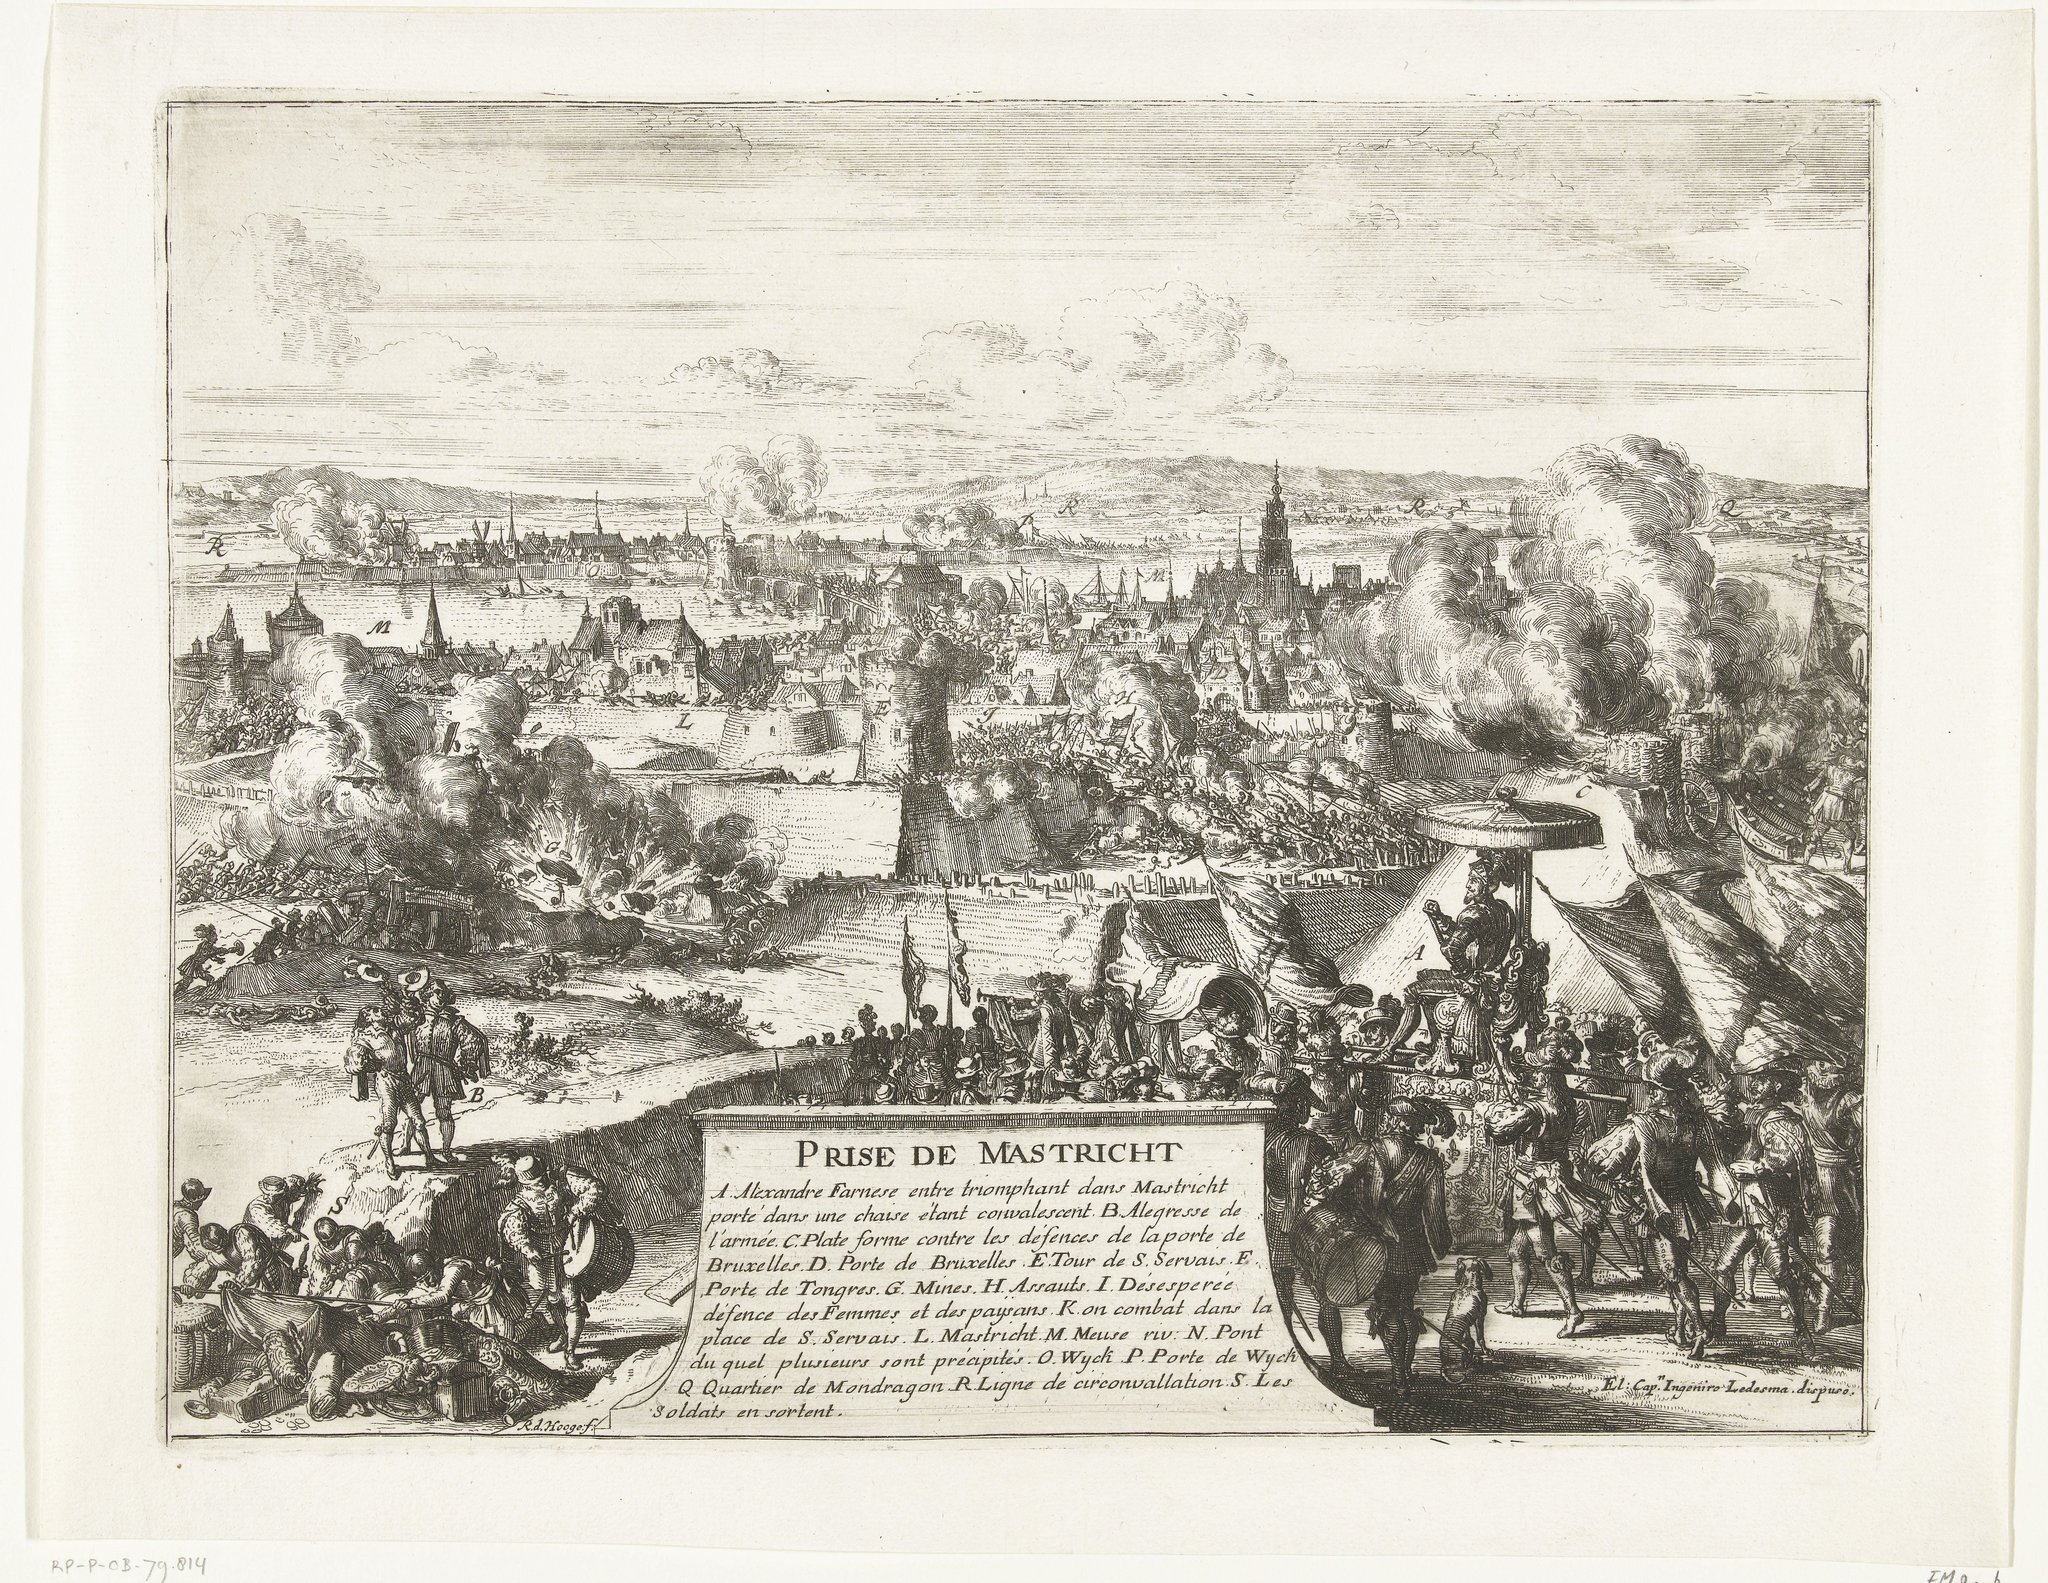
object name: history print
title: Inname van Maastricht door de hertog van Parma, 1579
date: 1670-1699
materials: paper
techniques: etching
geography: northern netherlands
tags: rome, alessandro farnese (landvoogd van de nederlanden en hertog van parma en piacenza), (carrying a person in a) sedan-chair, capture of city (after the siege), maastricht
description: Inname van Maastricht door het leger van de hertog van Parma, 29 juni 1579. Farnese wordt zittend op een stoel onder een parasol de stad binnengedragen. Middenonder een cartouche met de titel en de legenda A-S in het Frans.